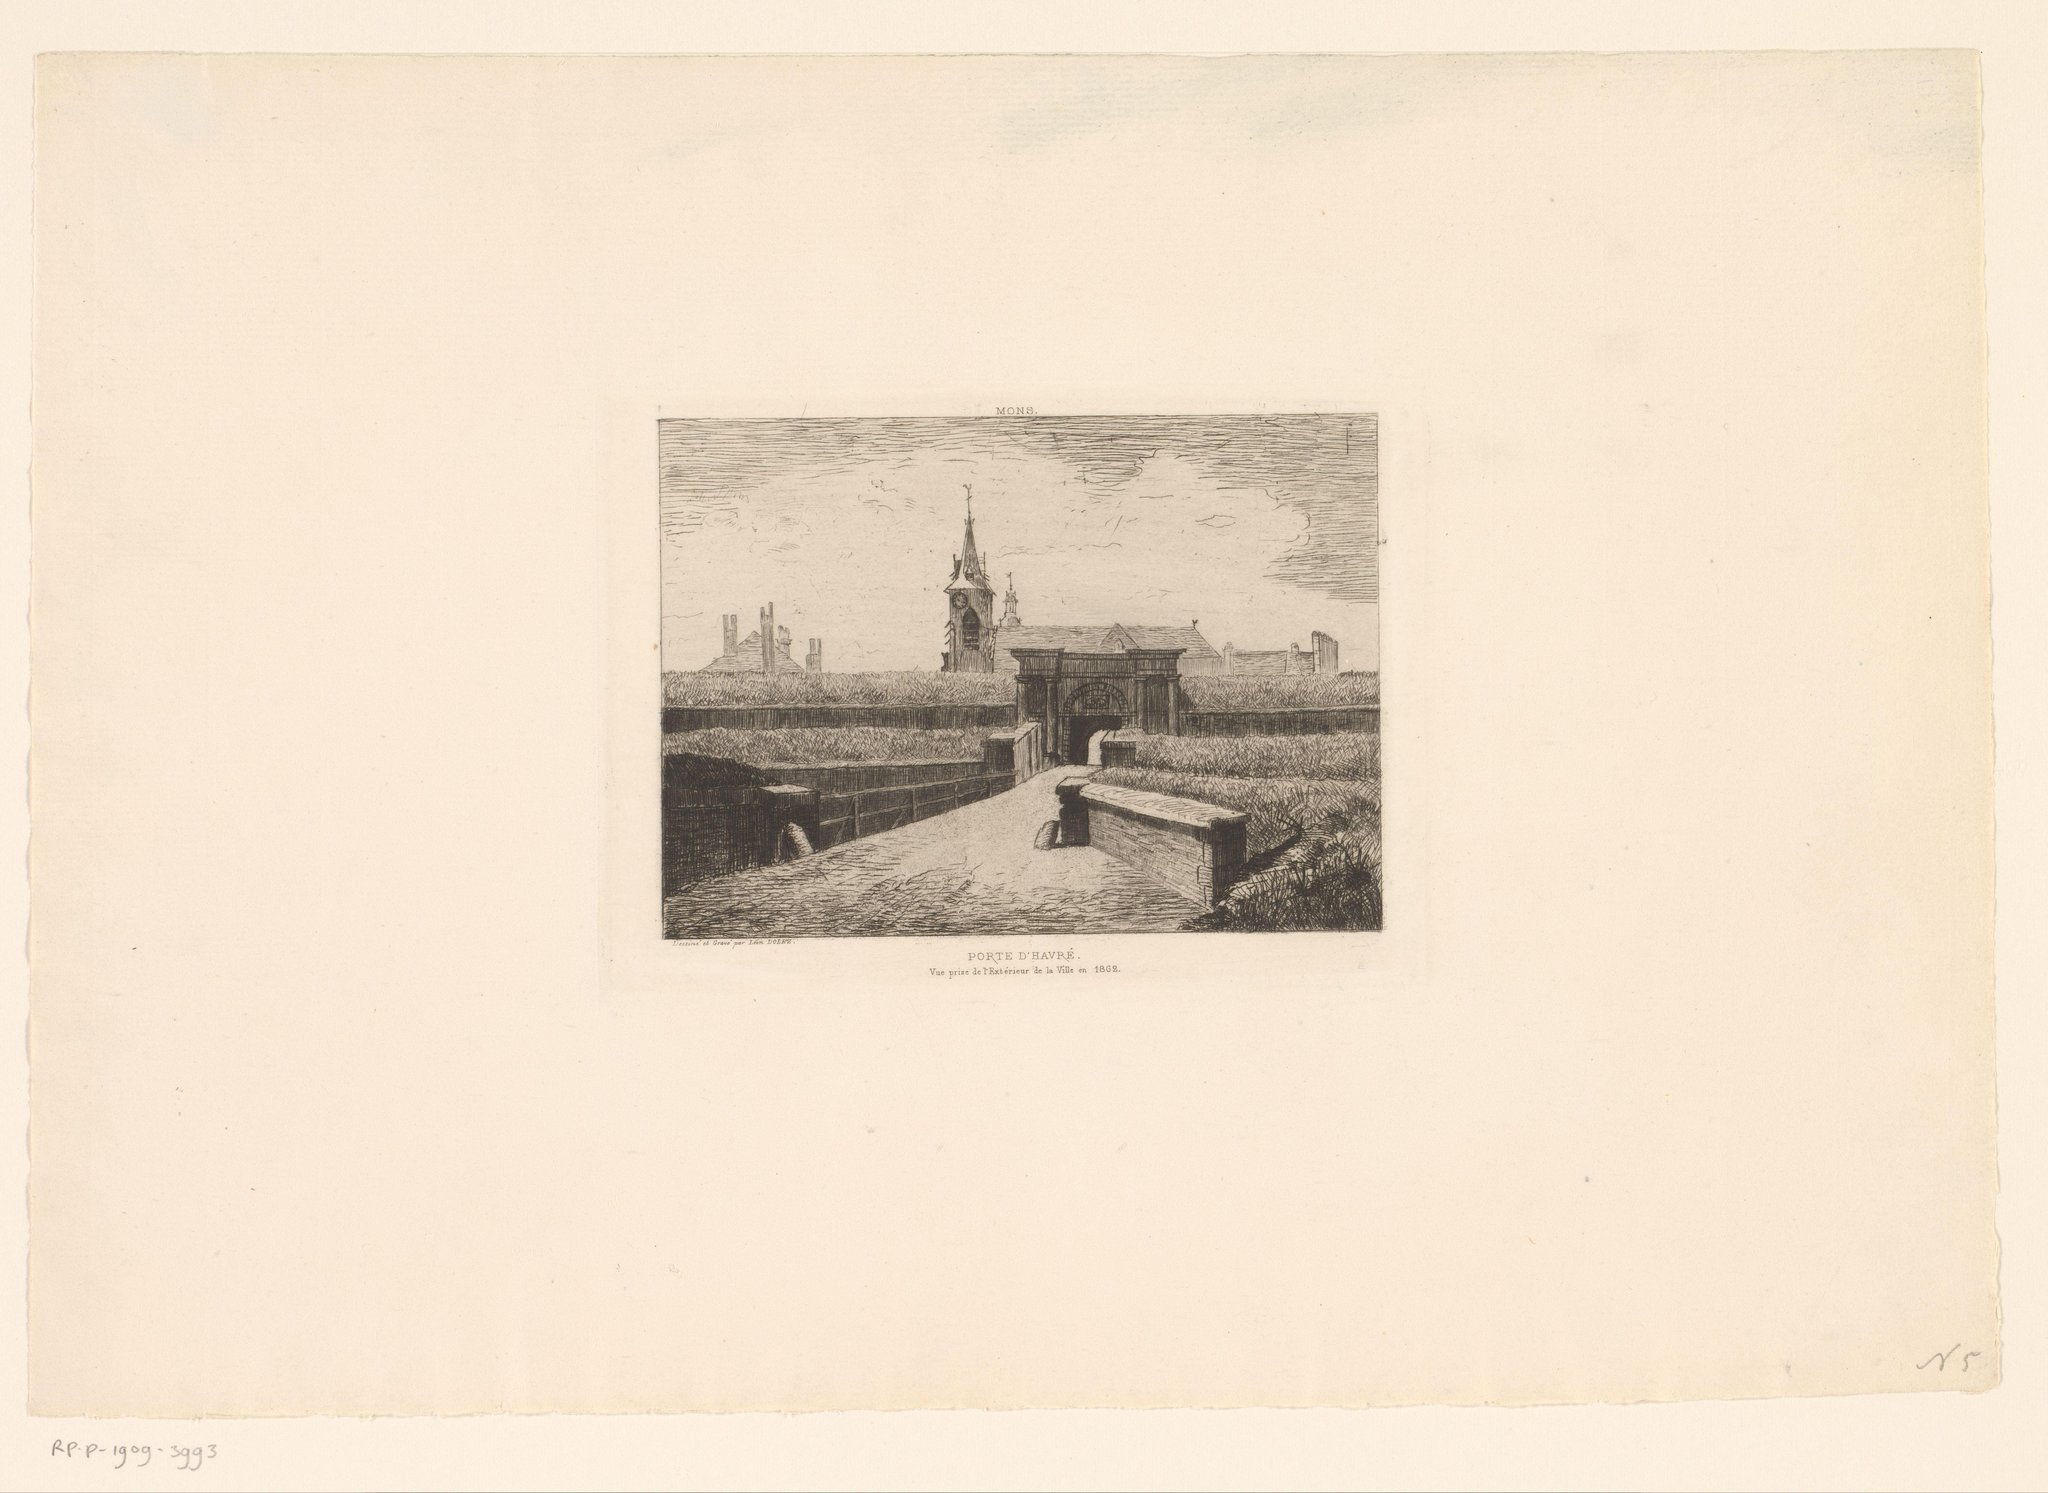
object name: print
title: Fortifications de Mons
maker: léon dolez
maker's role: print maker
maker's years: 1837-1902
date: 1875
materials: paper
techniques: drypoint, etching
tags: church (exterior), city-gate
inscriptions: collector's mark: Lugt 2228